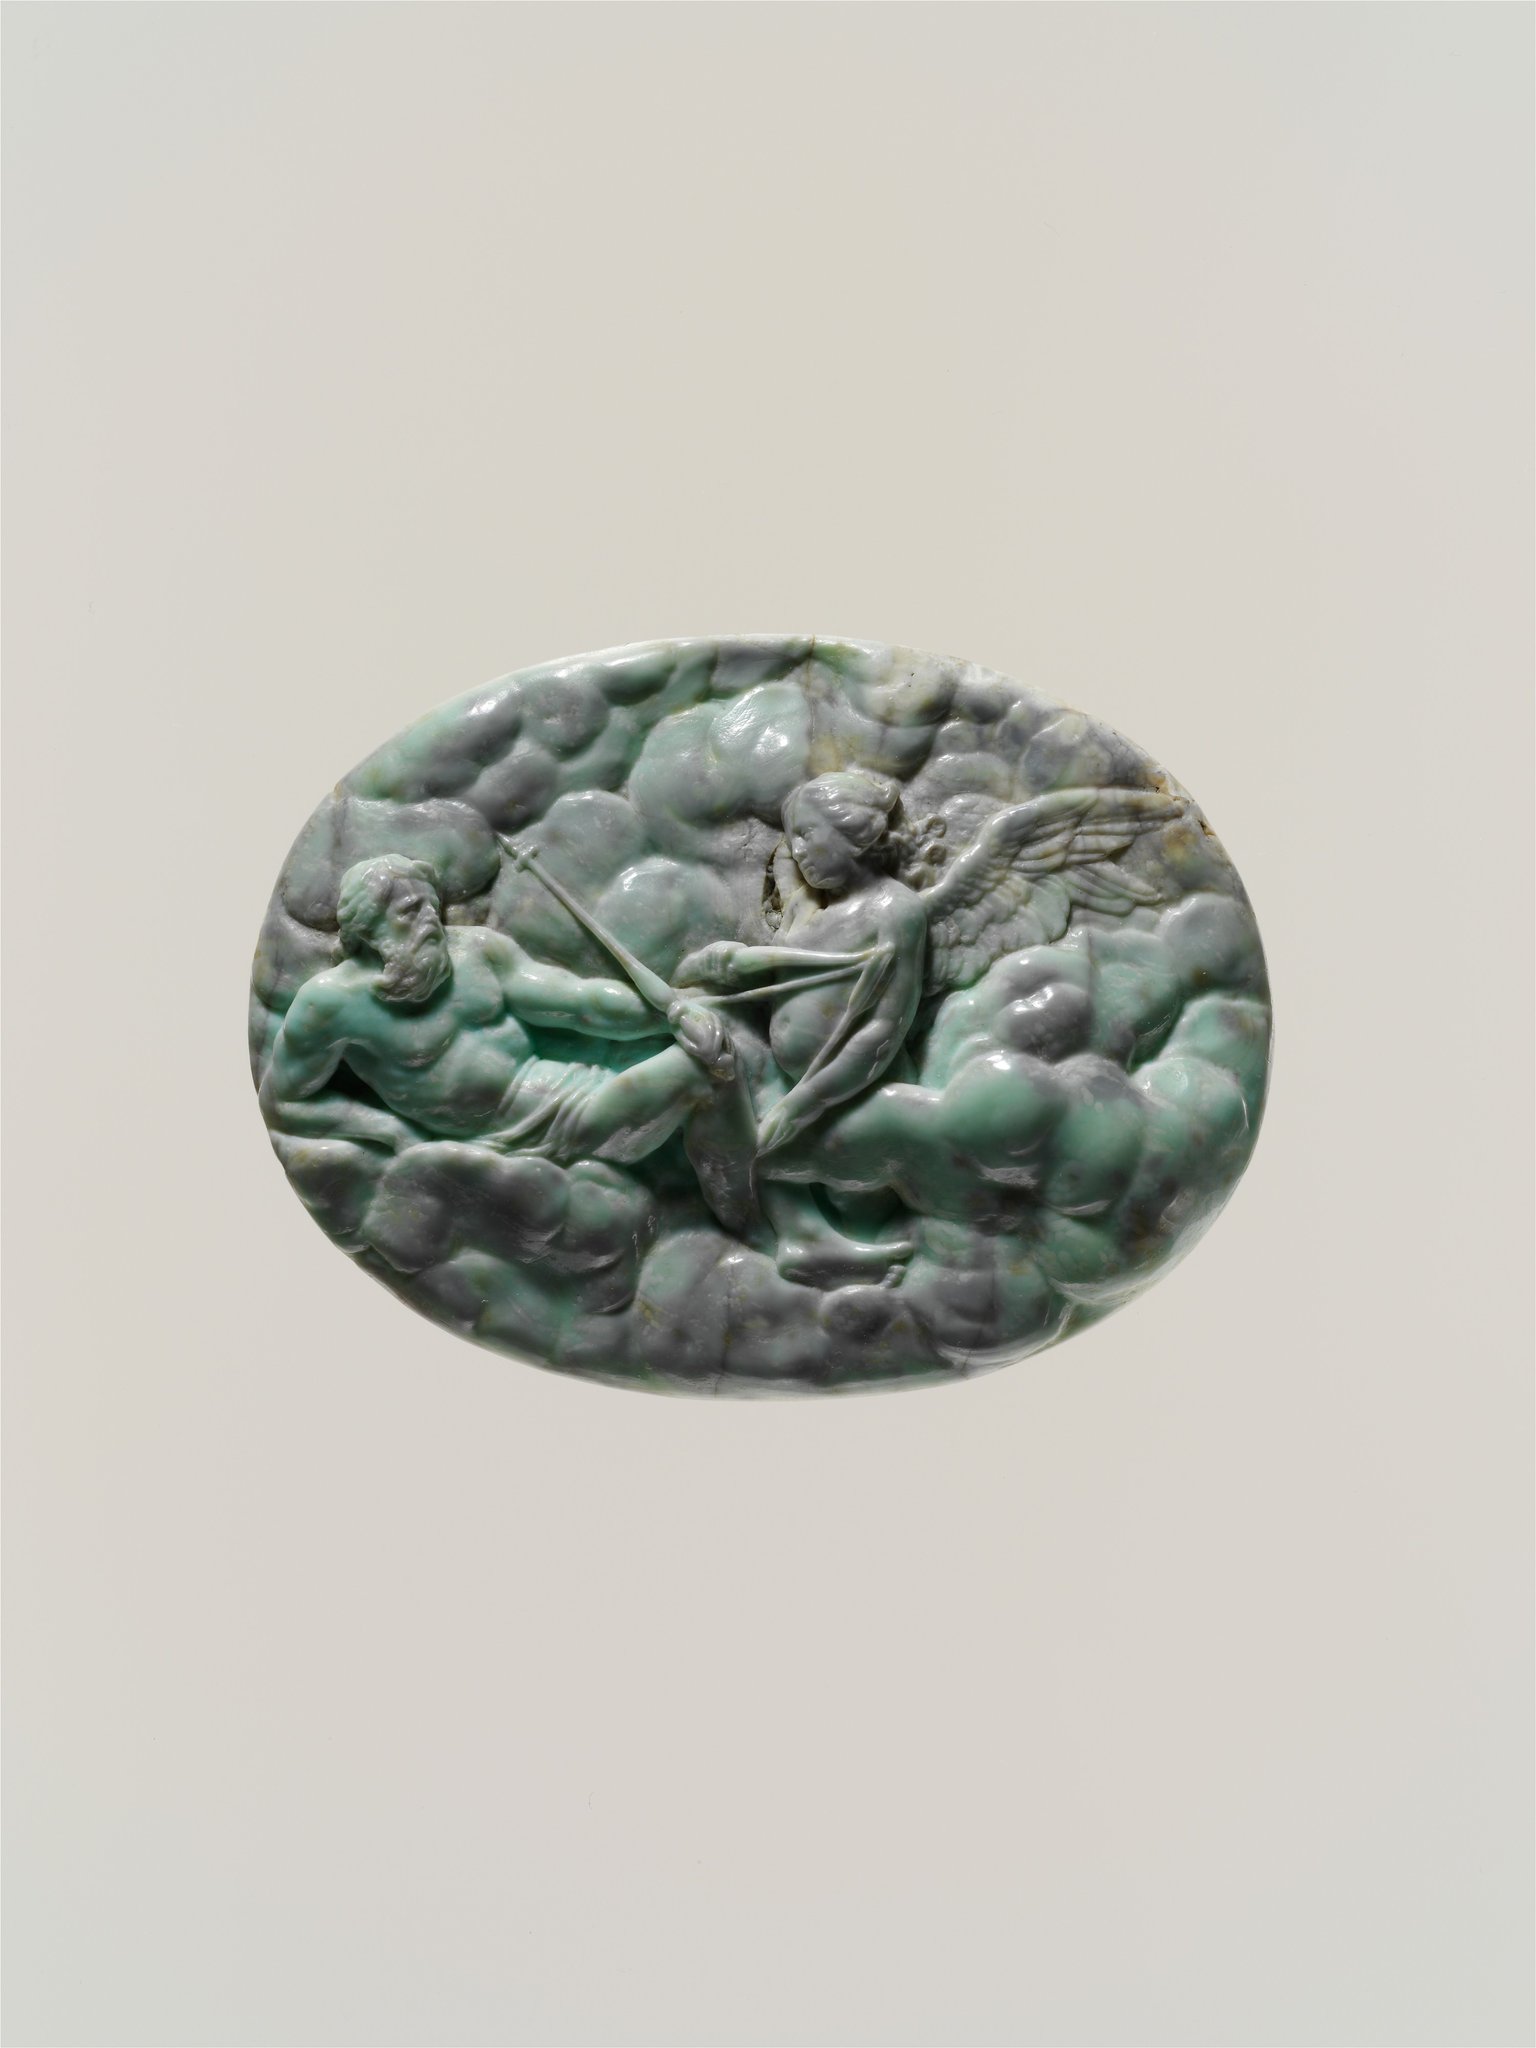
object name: cameo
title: Cupid before Jupiter amid Clouds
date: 1667-1700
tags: cupid,jupiter,clouds